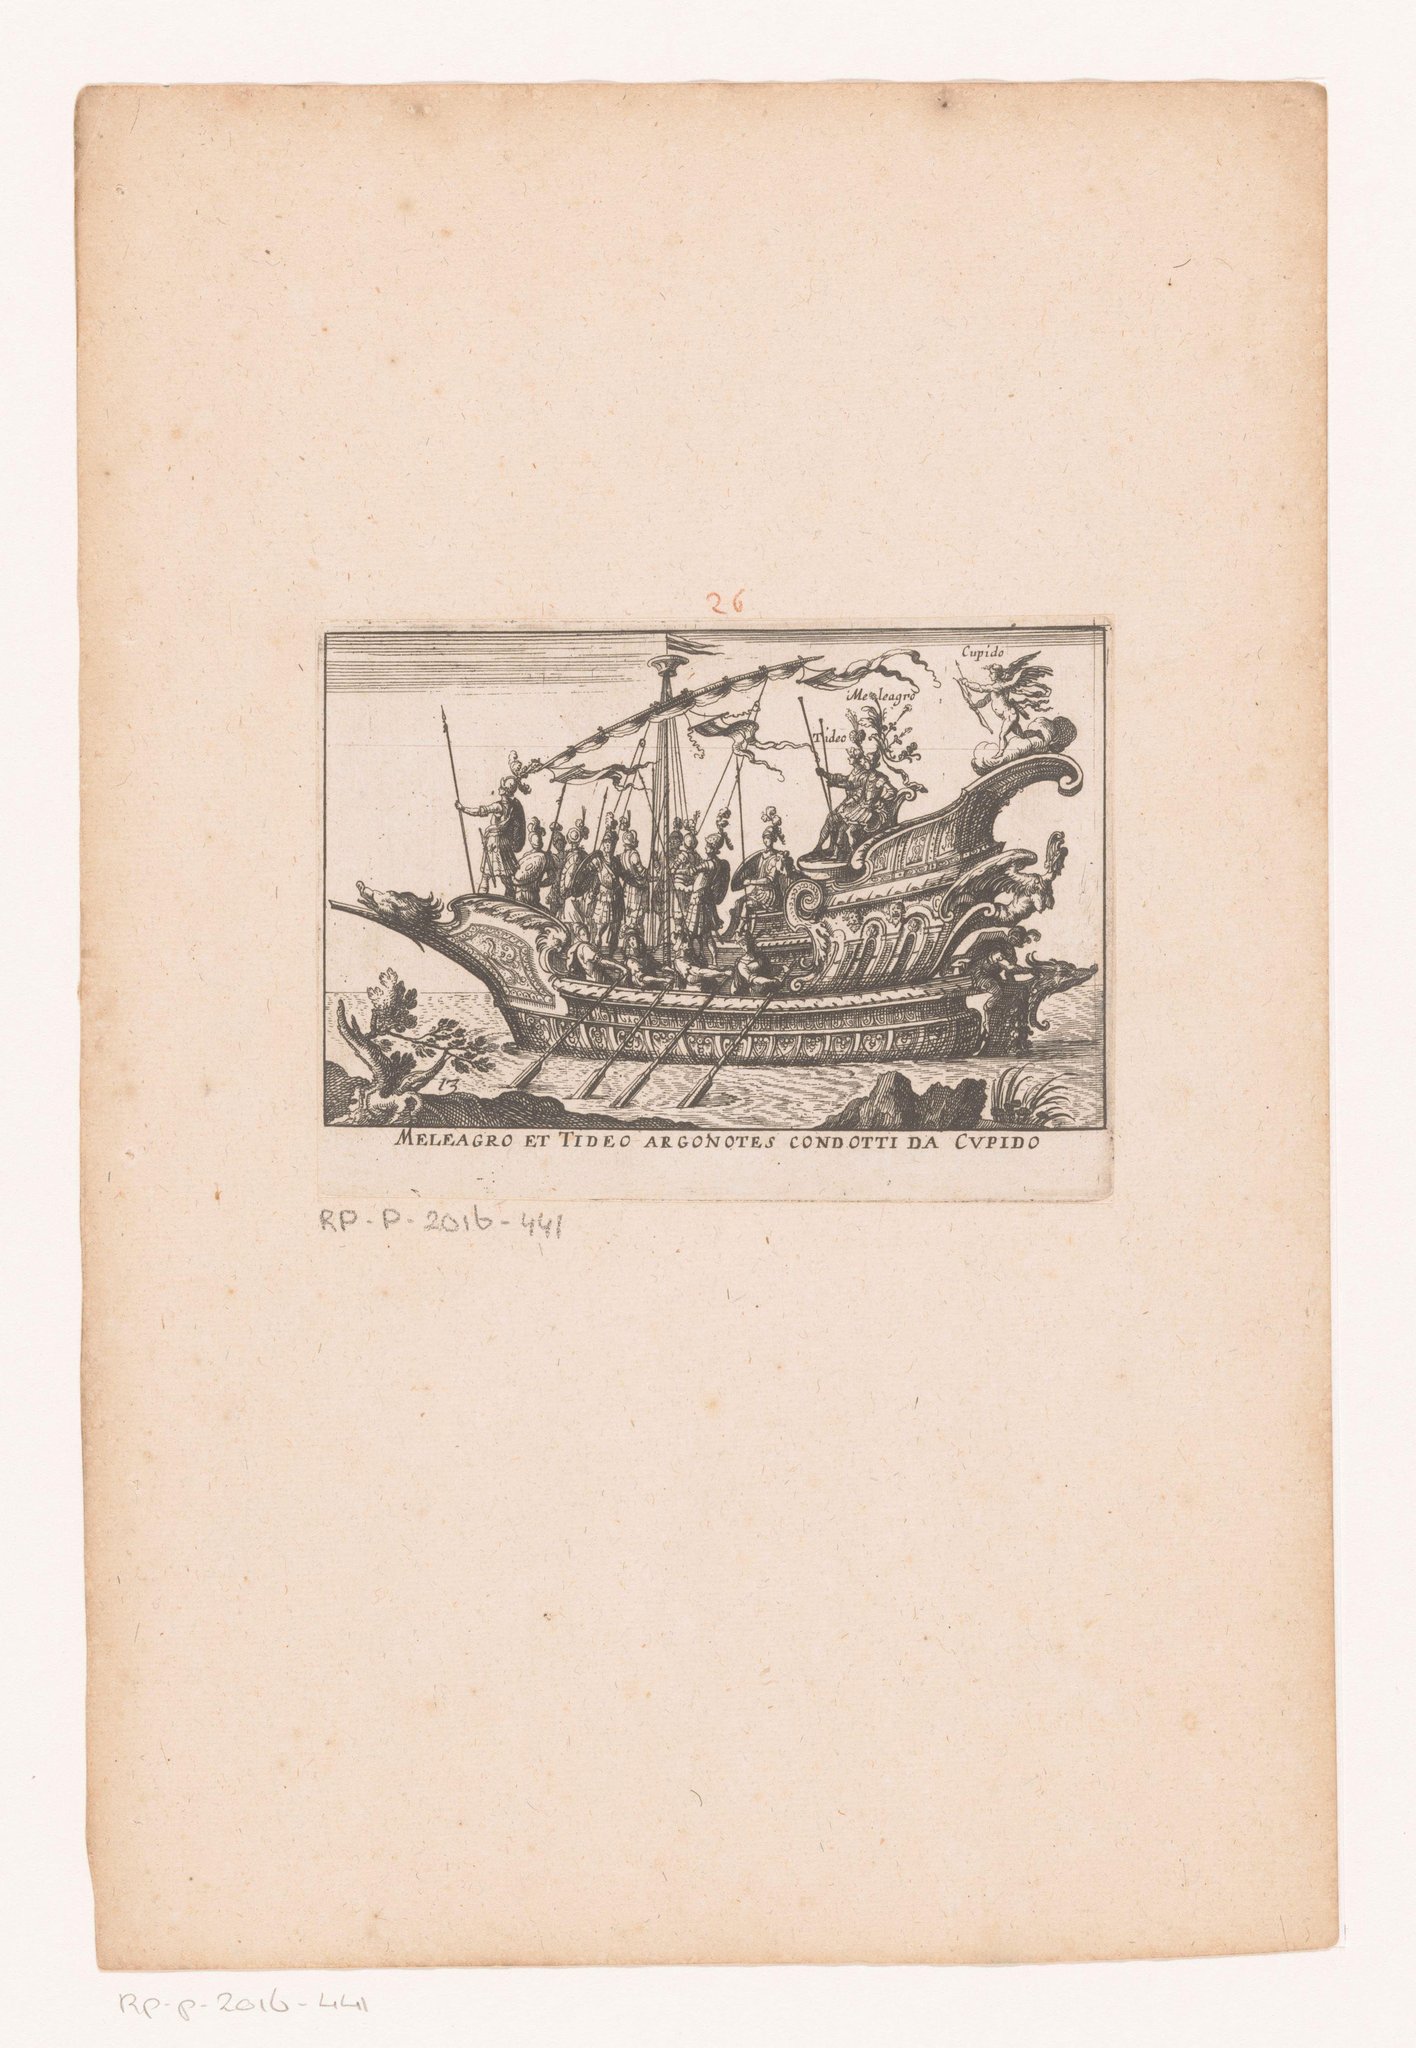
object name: print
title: Le Magnifique Carousel fait sur le fleuve de l'Arne à Florence pour le Mariage du grand Duc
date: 1624-1631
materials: paper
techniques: etching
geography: paris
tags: ships (in general), (story of) cupid, amor (eros), the story of the argonauts: the quest for the golden fleece, (story of) meleager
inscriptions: number: ‘26’, collector's mark: Lugt 2228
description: Een schip met zwijnskop als boegbeeld, op het achtersteven zitten Meleager, Tydeus en Amor.